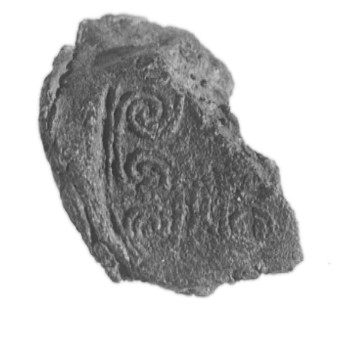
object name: sealing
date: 2030-1640 BCE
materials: clay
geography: egypt